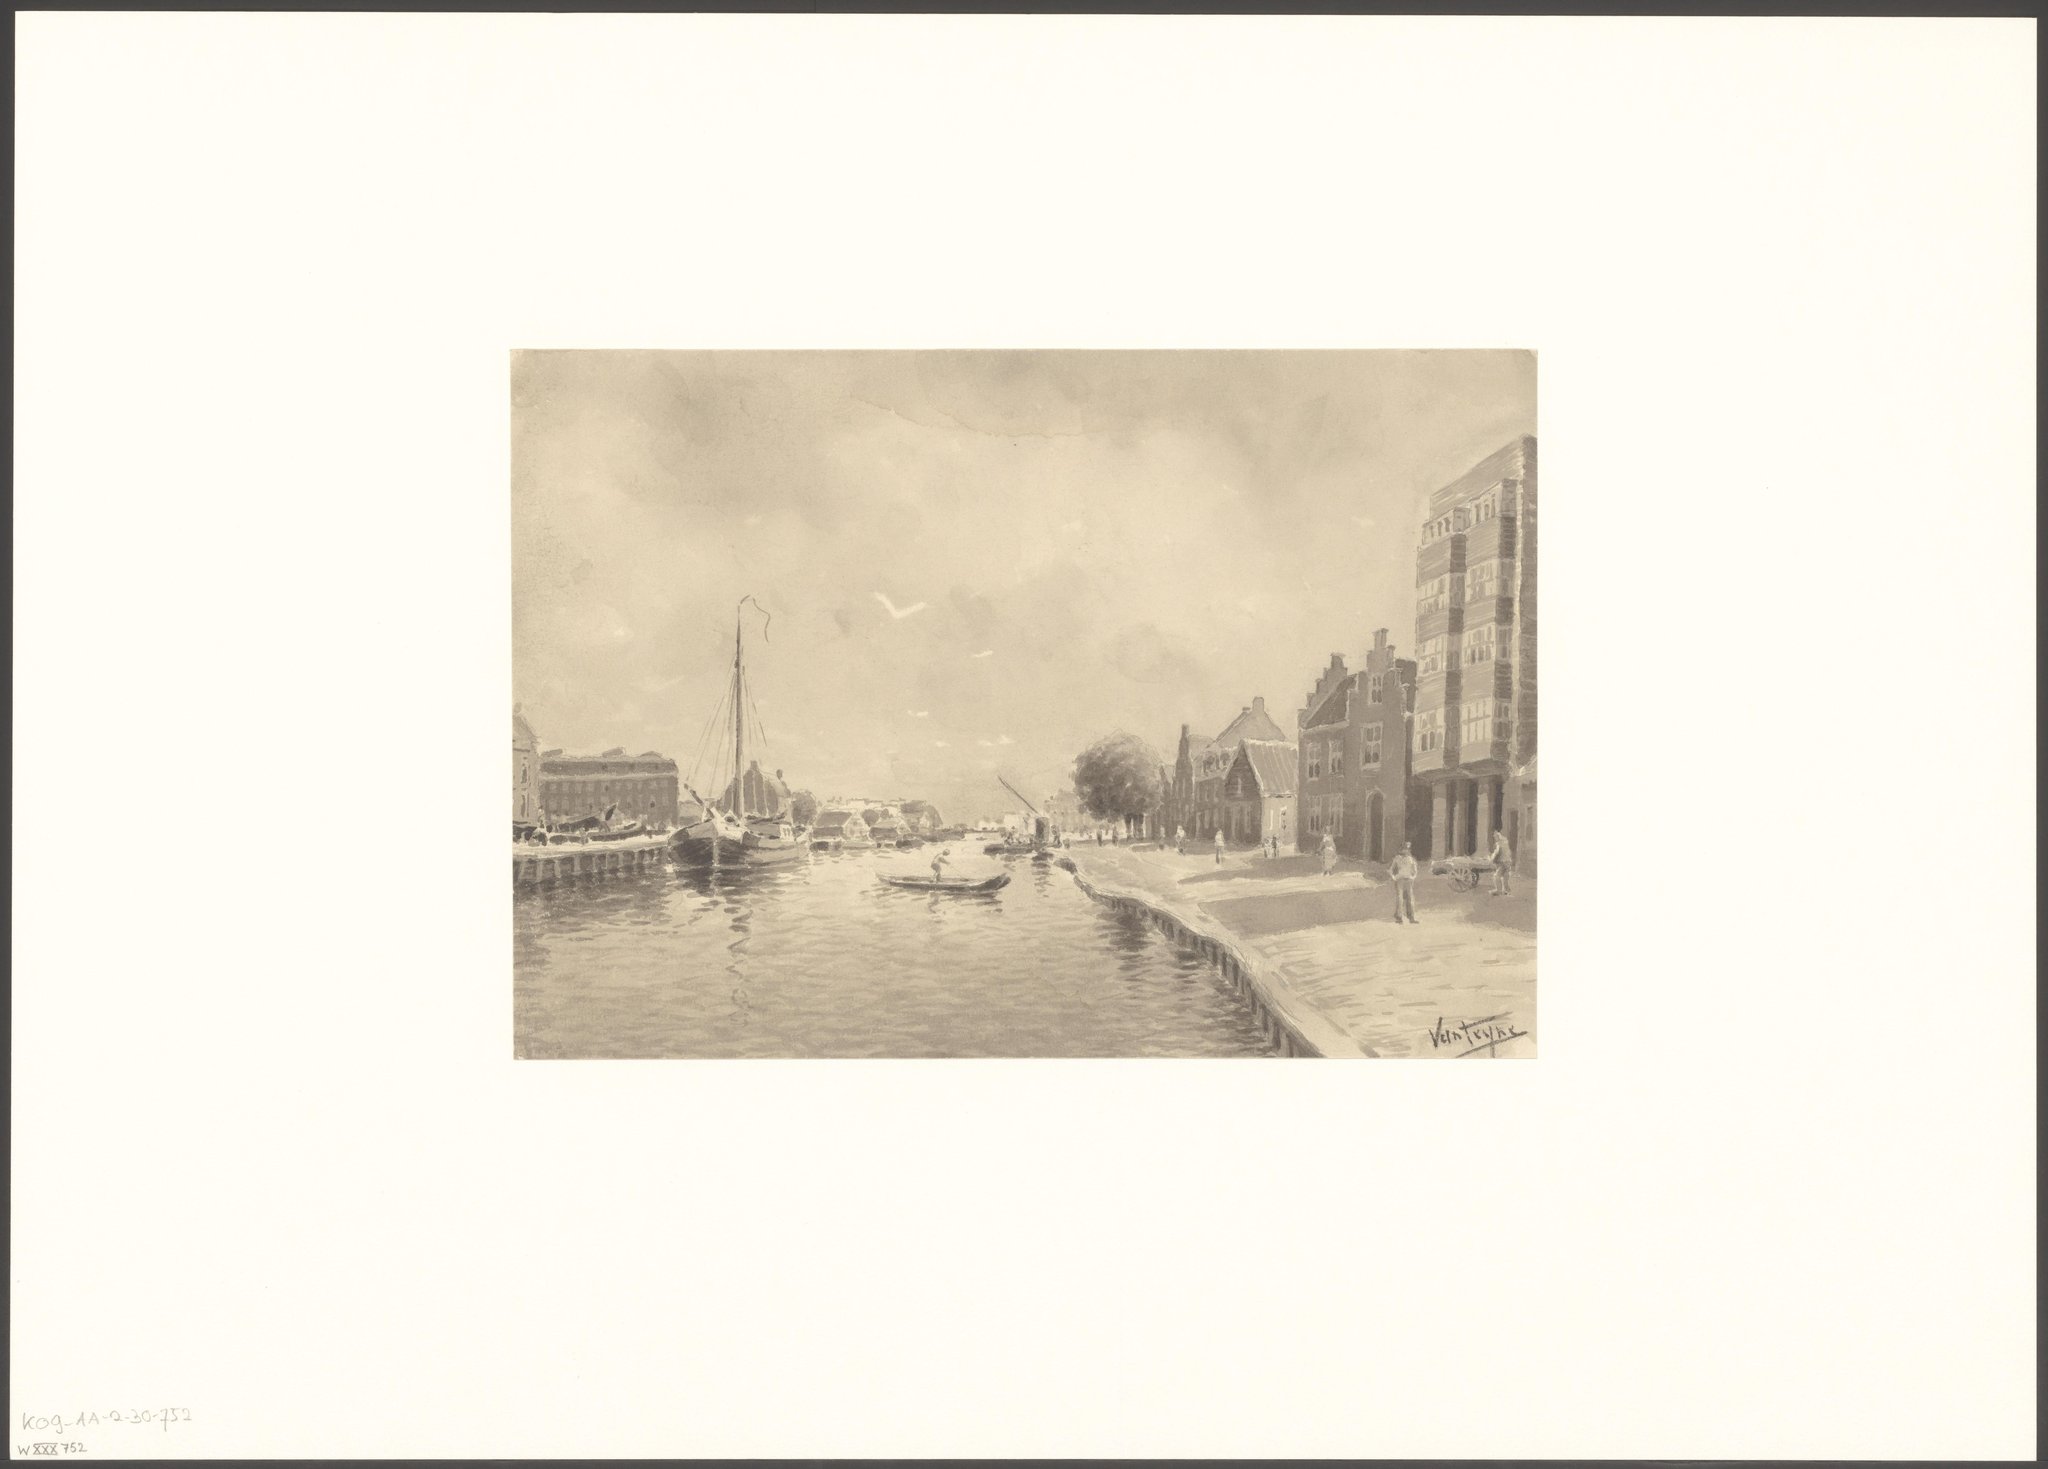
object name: drawing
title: Gezicht op de Baarsjesweg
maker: anthonie van teijn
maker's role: draughtsman, painter, print maker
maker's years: 1863-1943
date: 1907-1927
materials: ink, paper, pencil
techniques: brush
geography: amsterdam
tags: sailing-ship, sailing-boat, city-view in general; 'veduta', canal, boat propelled by man or animal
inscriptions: collector's mark: Lugt 800a, signature: ‘VanTeyne’, inscription: ‘Baarsjes weg. nieuw (...) Juli 1927. / vanEck’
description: Tekening binnen de Atlas Van Eck ingedeeld op wijknummer 30.